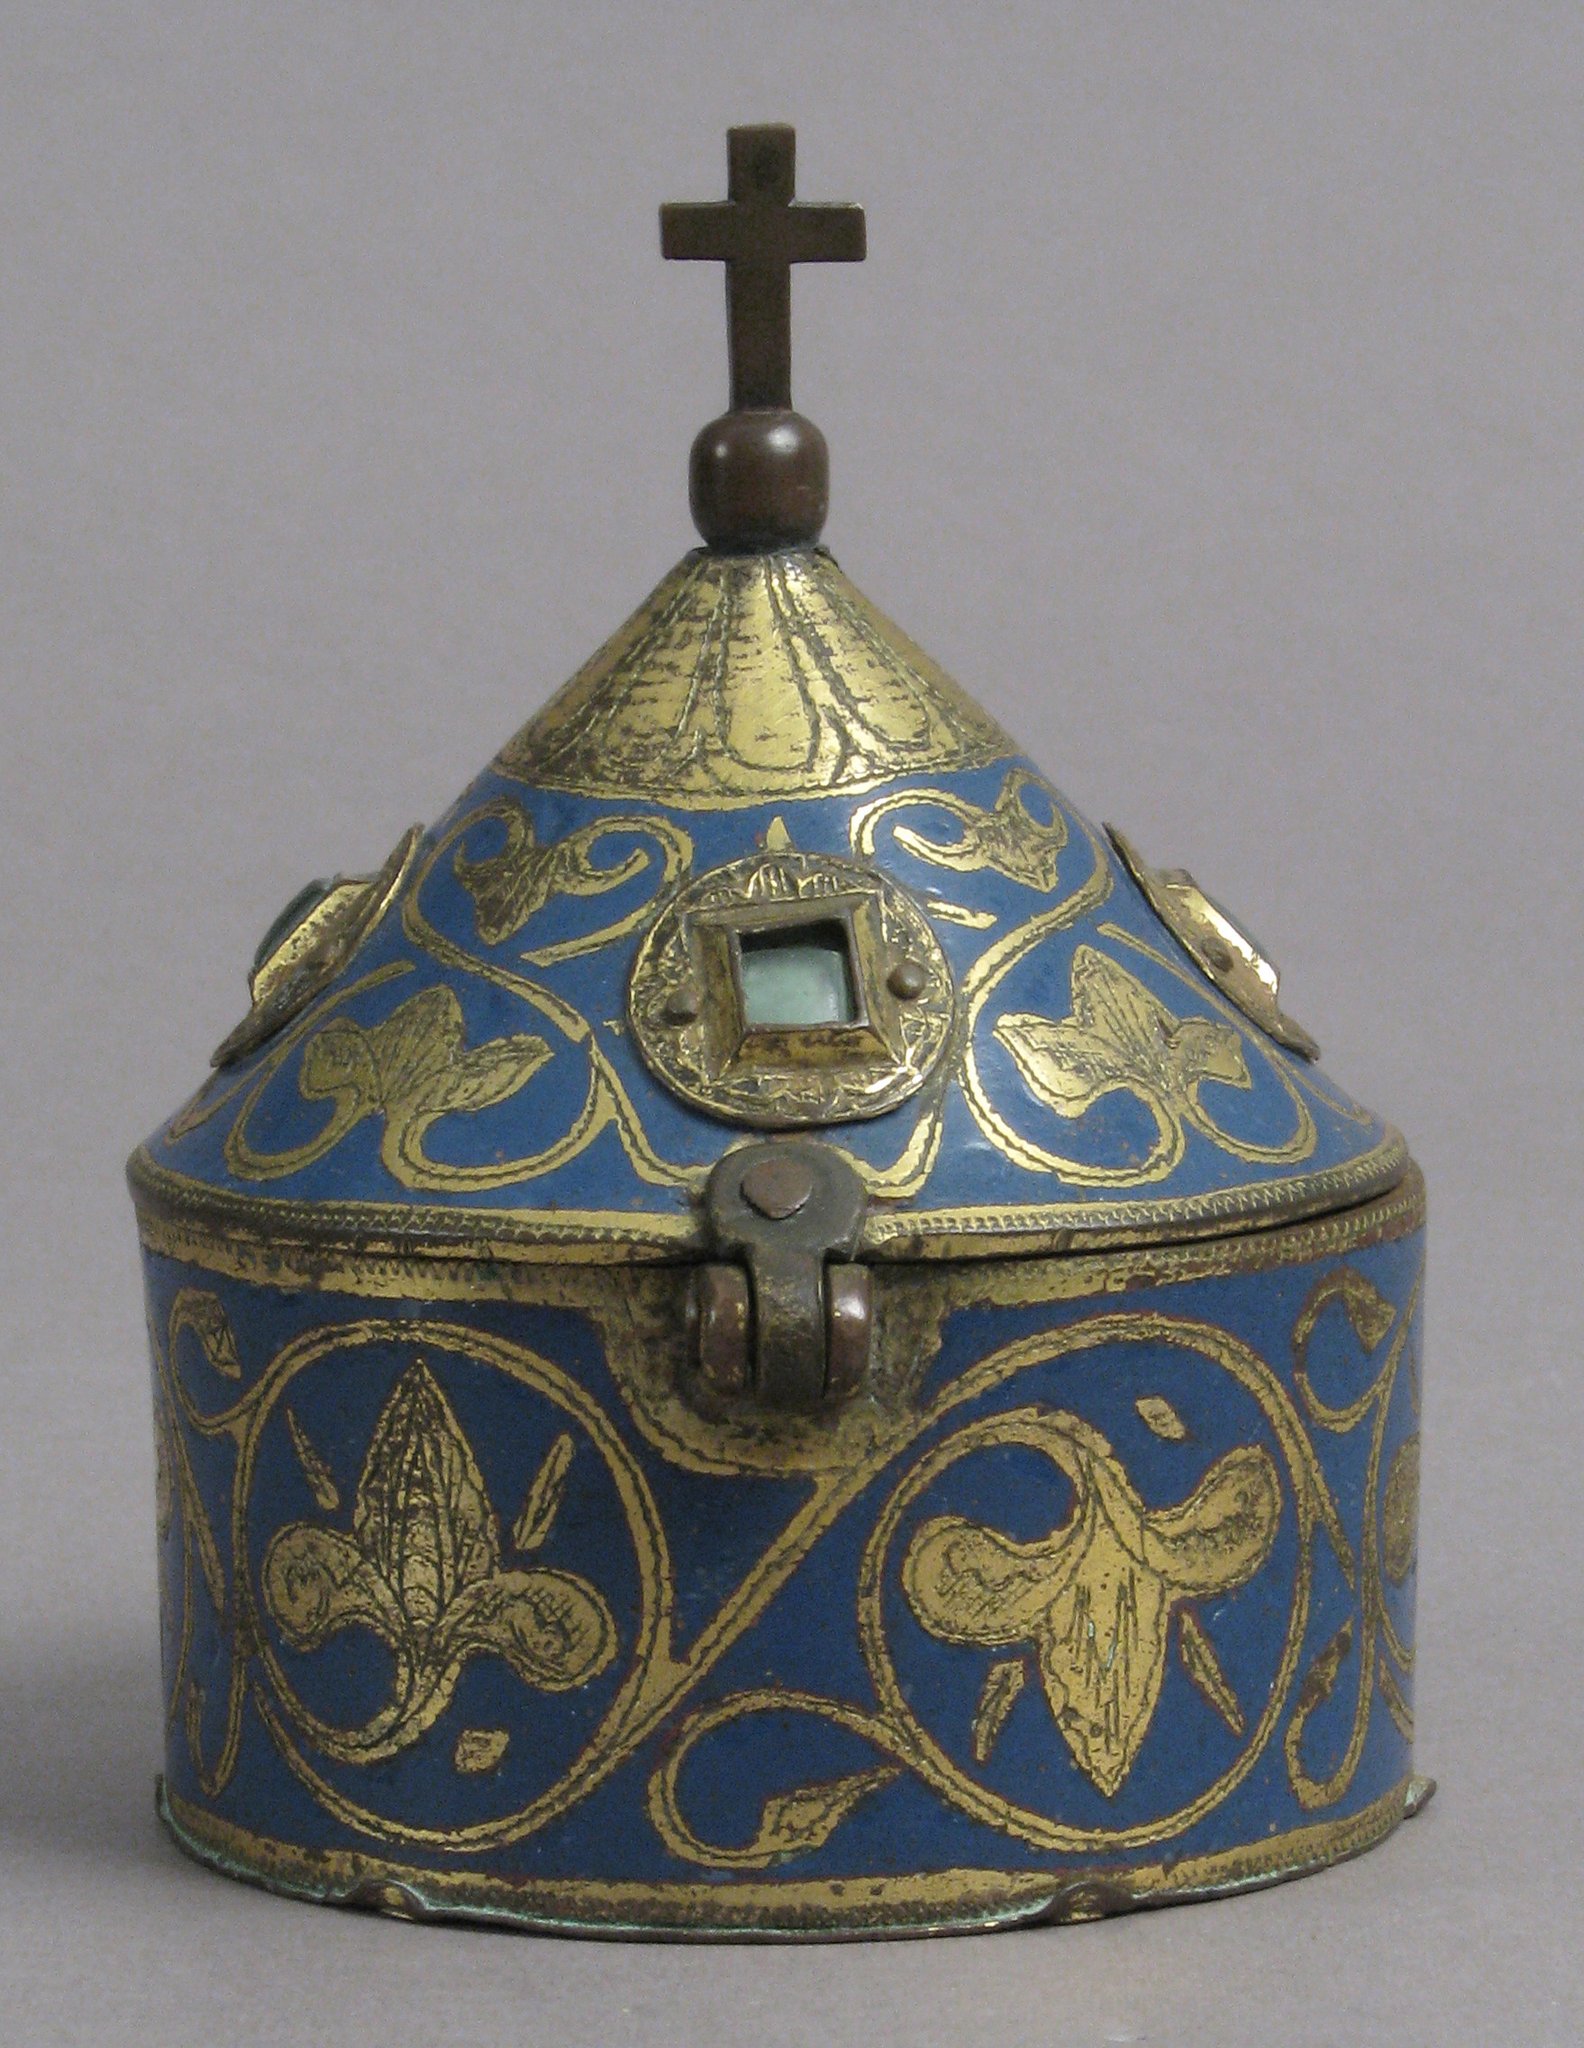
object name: pyx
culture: french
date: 1201-1300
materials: gilt copper, enamel, glass, paste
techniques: enamel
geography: france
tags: cross